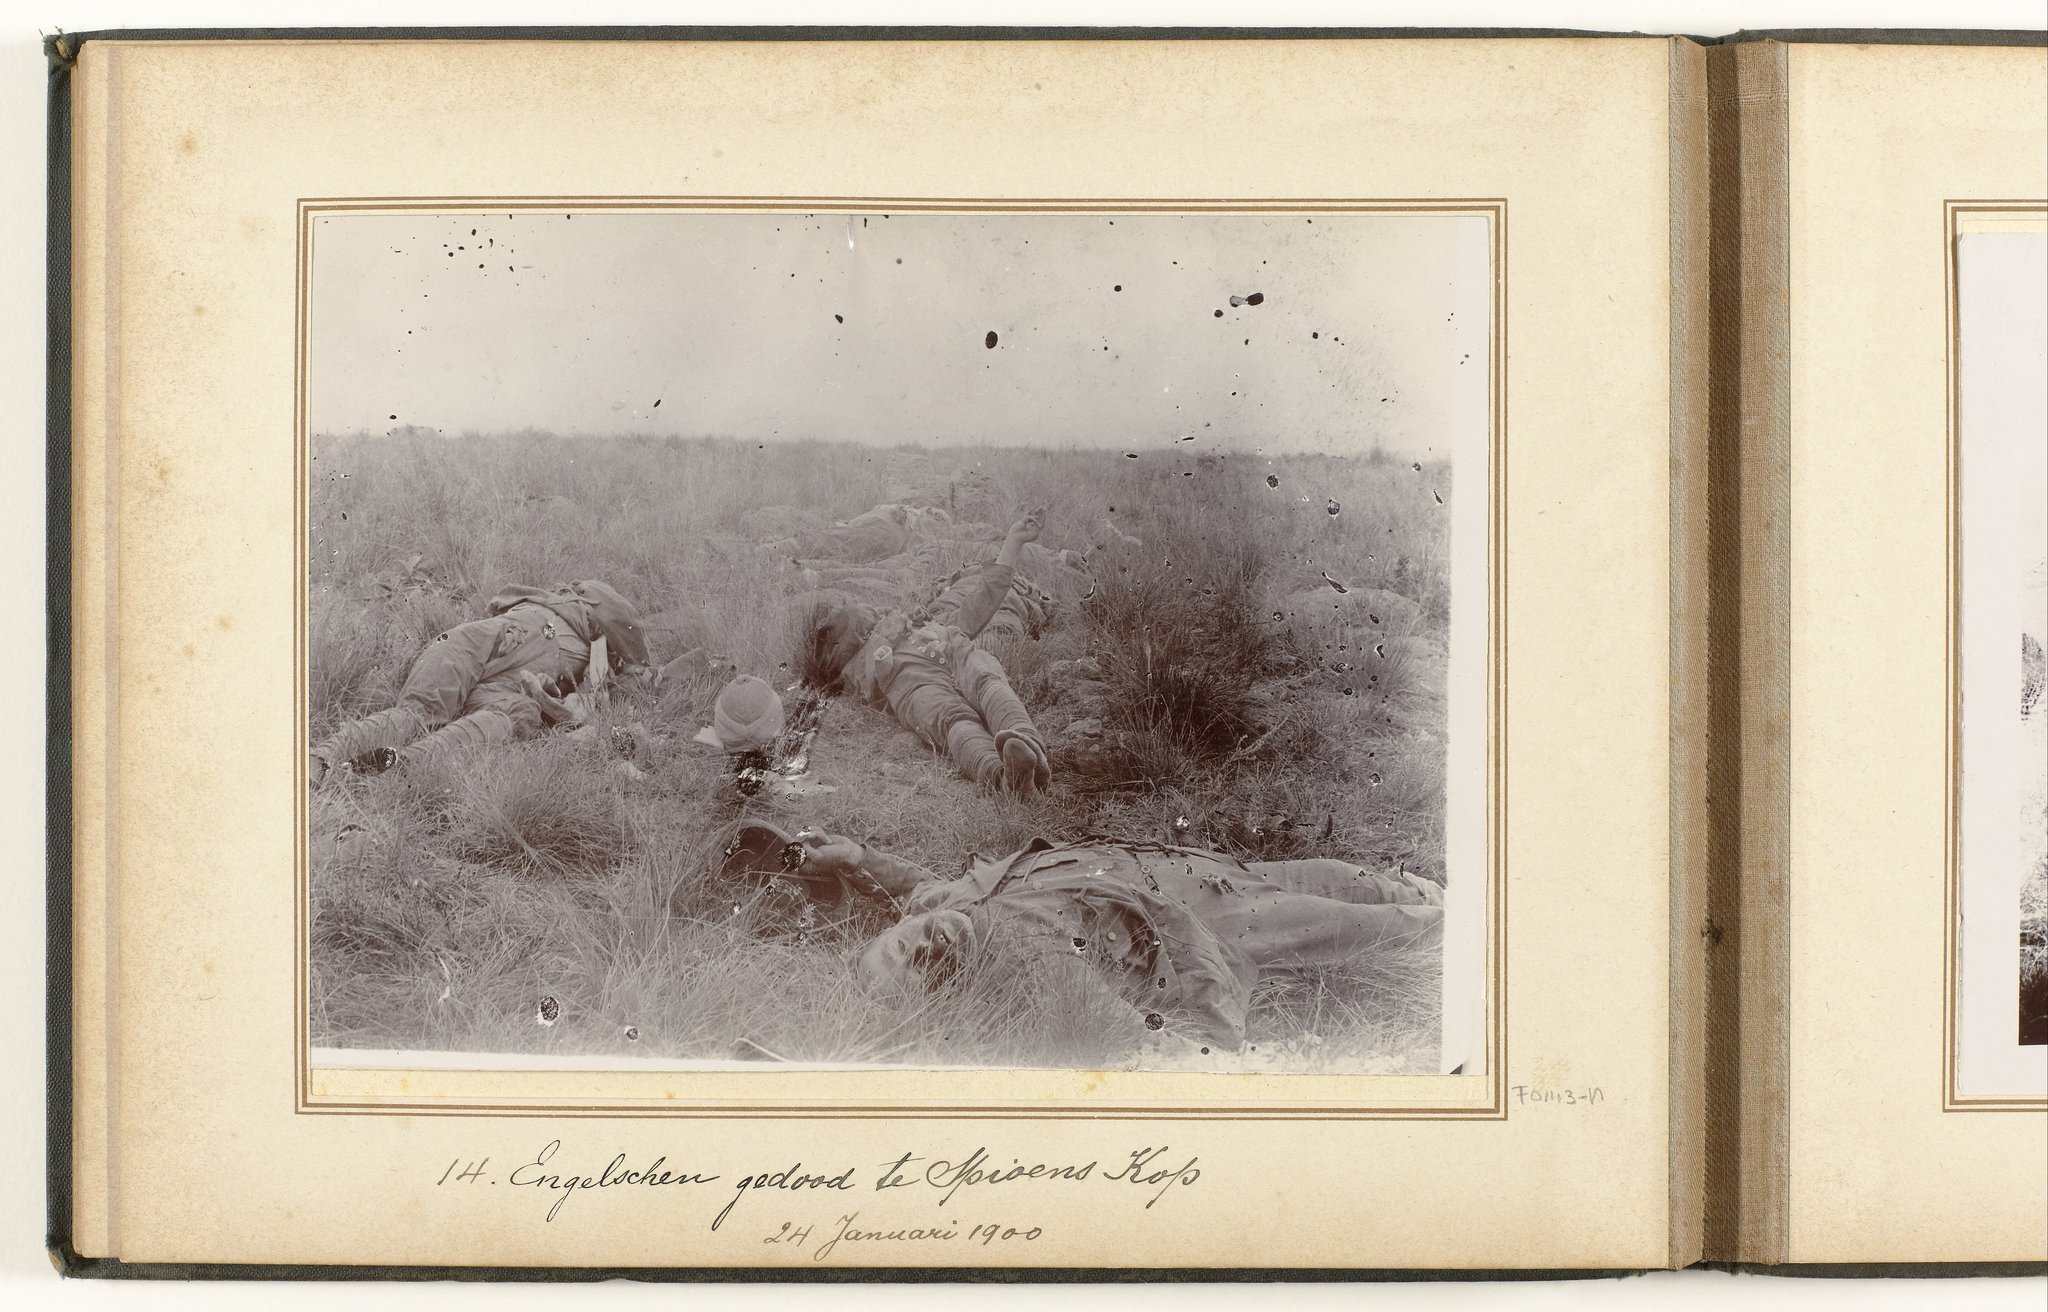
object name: photograph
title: Engelse slachtoffers van de strijd bij Spionkop in Zuid-Afrika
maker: Anonymous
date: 1900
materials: cardboard, paper, photographic support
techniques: gelatin silver print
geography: spionkop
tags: horrors of war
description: Onderdeel van Fotoalbum met opnames van de Tweede Boerenoorlog (1899-1902).